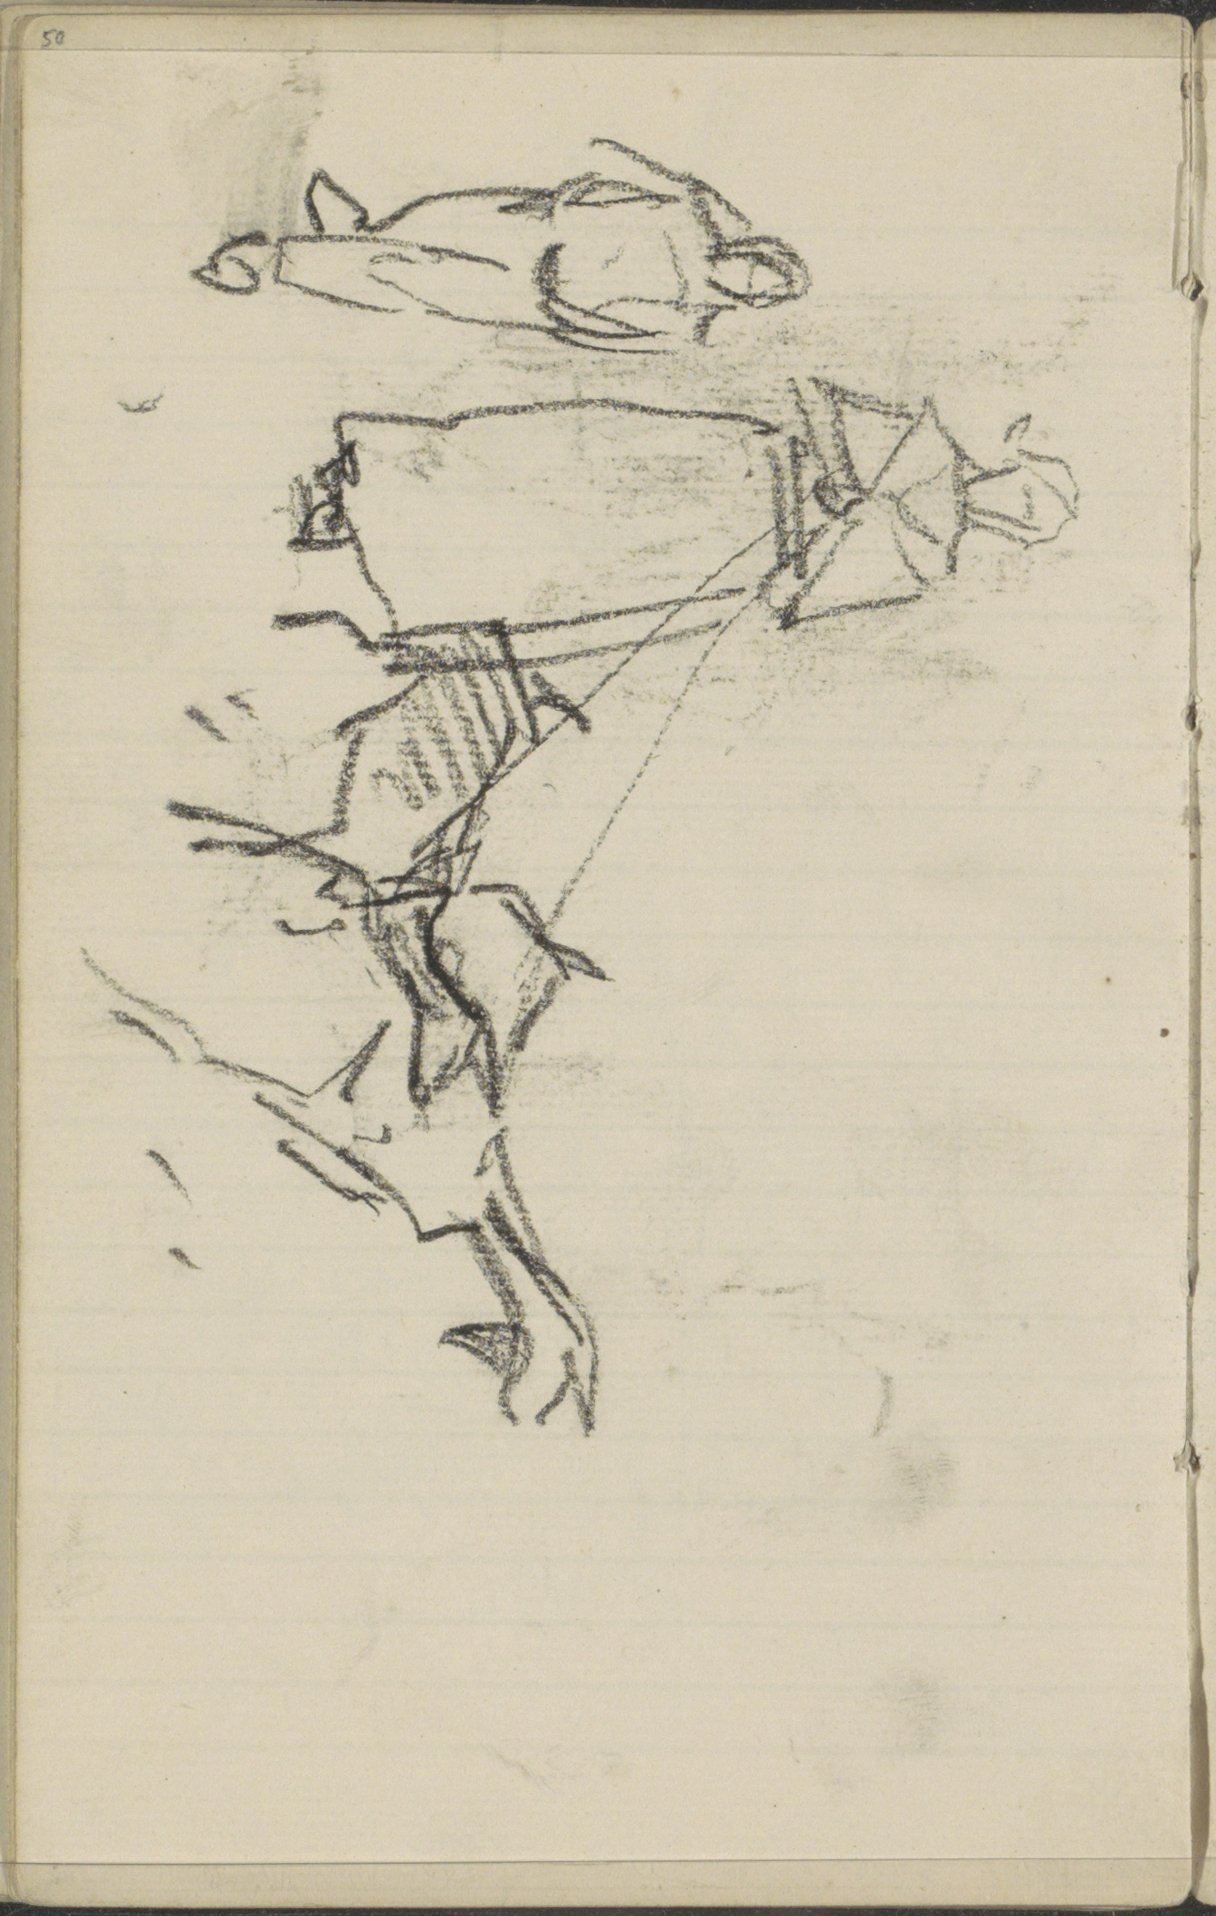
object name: sketchbook leaf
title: Lopende vrouw met twee geiten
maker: marius bauer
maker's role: draughtsman, print maker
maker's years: 1867-1932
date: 1881-1885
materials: chalk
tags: adult woman, boy (child between toddler and youth), walking, goat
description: De vrouw draagt een boeren kapje en heeft de geiten aan een touw. Naast haar loopt een kind. Pagina 50 uit een schetsboek met 26 bladen.